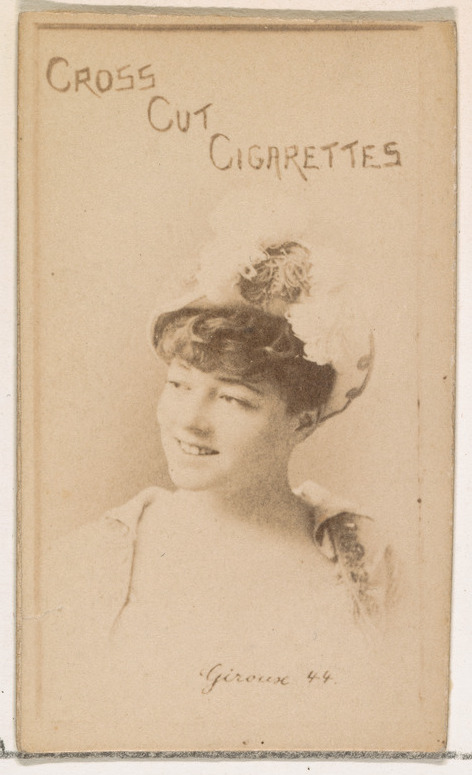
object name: print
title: Card Number 44, Giroux, from the Actors and Actresses series (N145-1) issued by Duke Sons & Co. to promote Cross Cut Cigarettes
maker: w. duke, sons & co.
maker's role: publisher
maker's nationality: american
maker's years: 1870-1920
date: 1880-1889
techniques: albumen silver print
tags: portraits,women,actresses